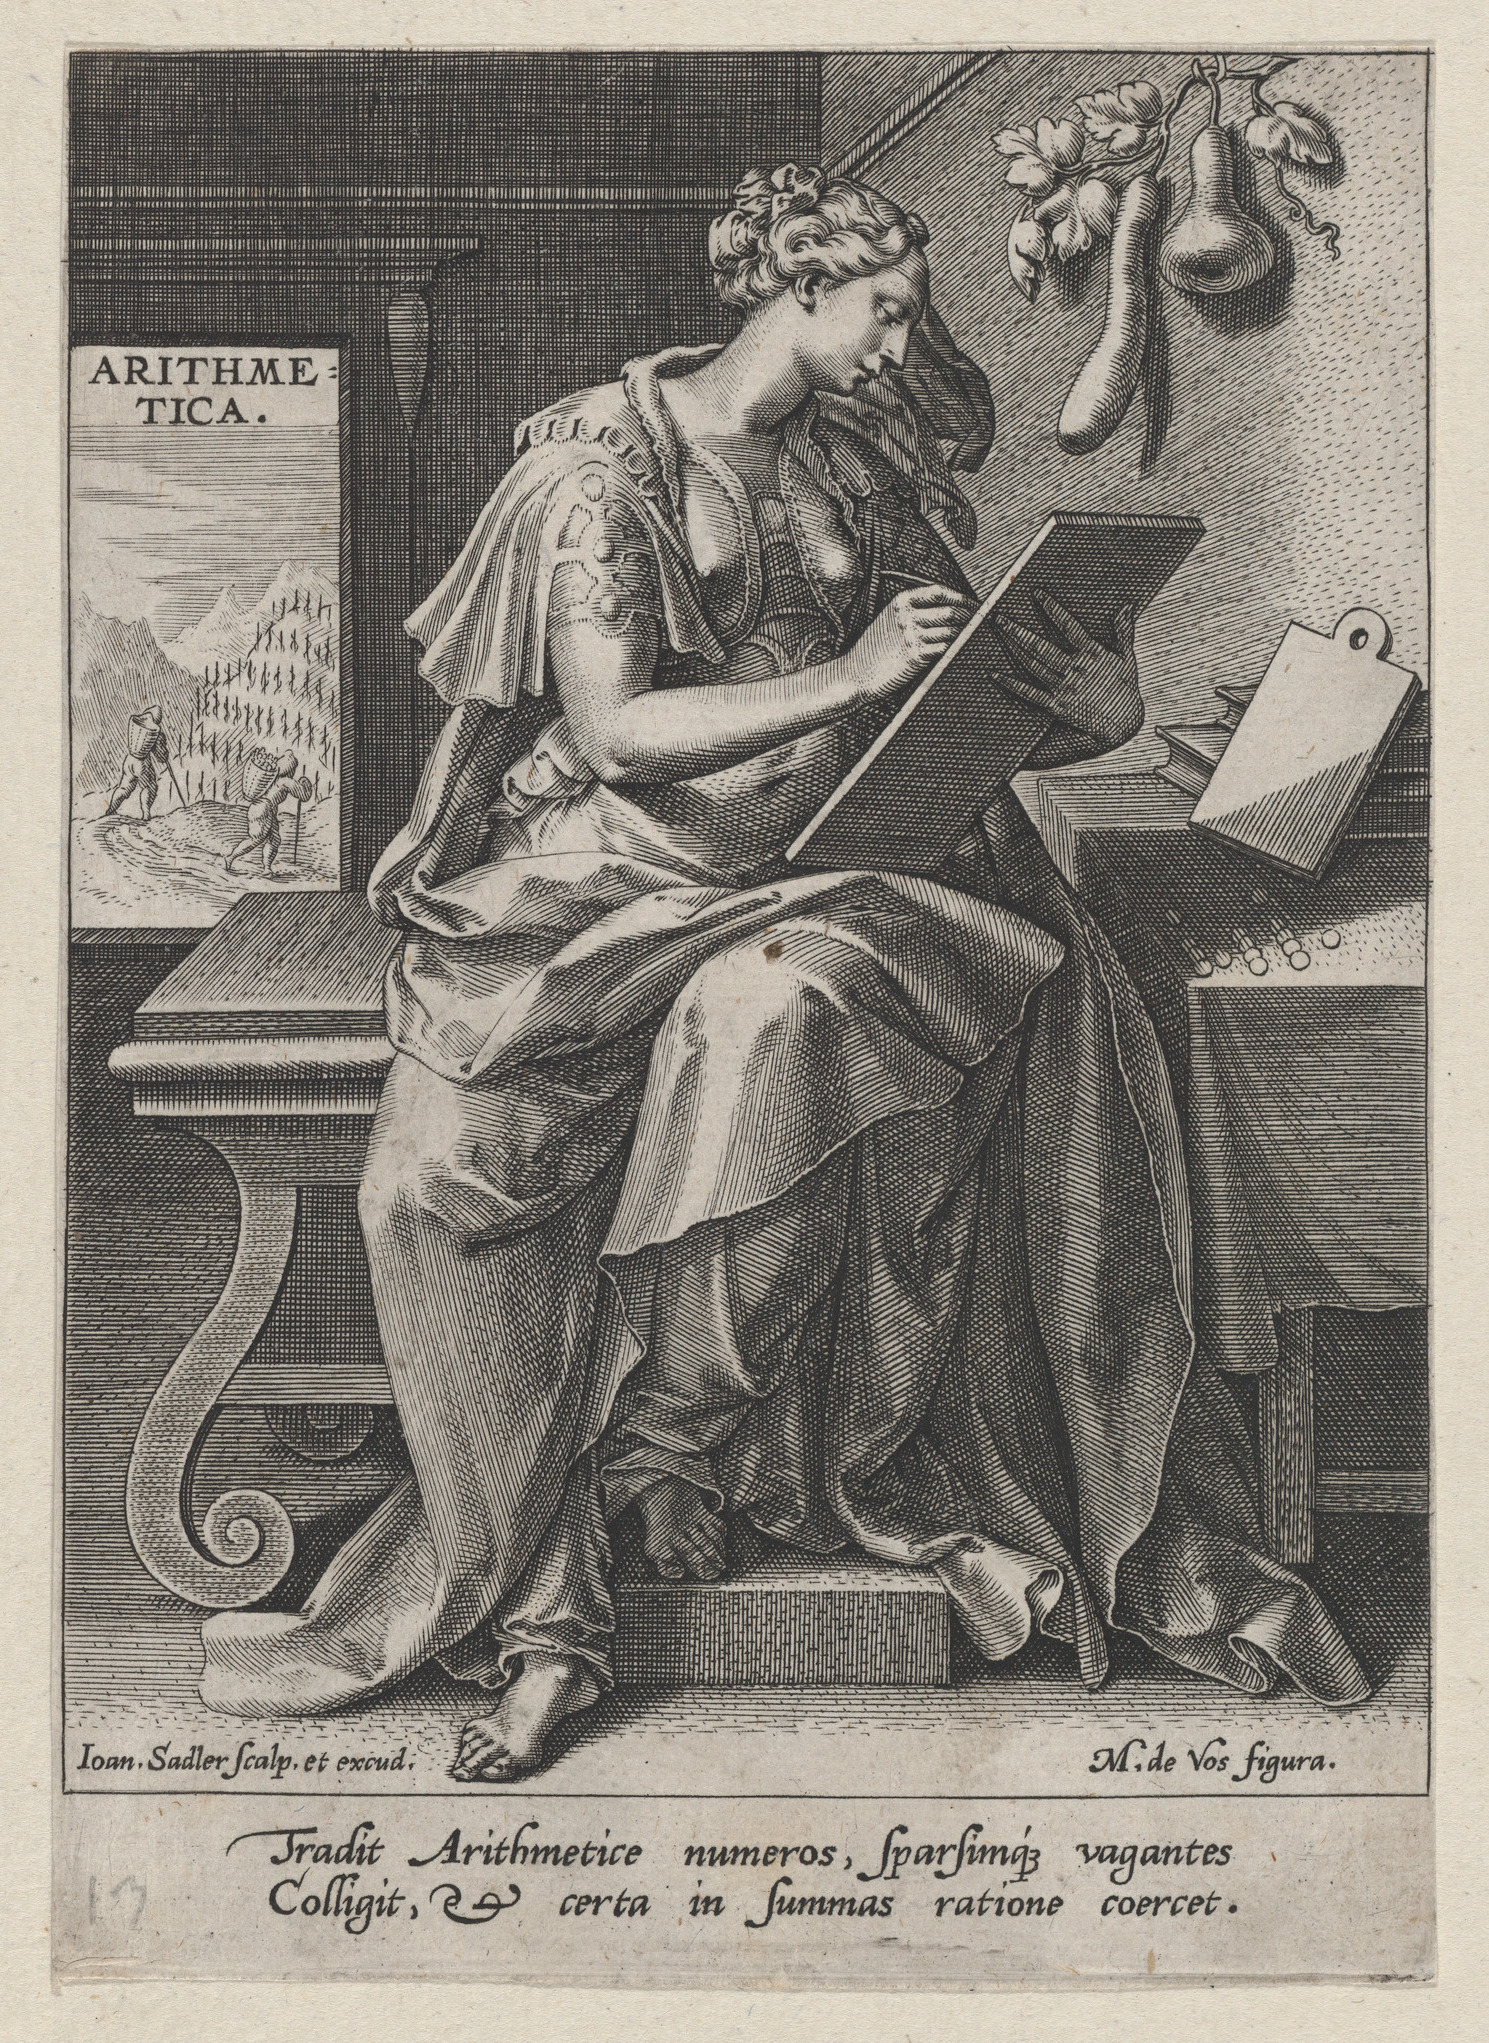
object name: print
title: Arithmetica, from "The Seven Liberal Arts"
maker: johann sadeler (i)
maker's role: artist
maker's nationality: netherlandish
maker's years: 1550-1601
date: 1570-1600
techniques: engraving, etching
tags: women,mathematics,writing